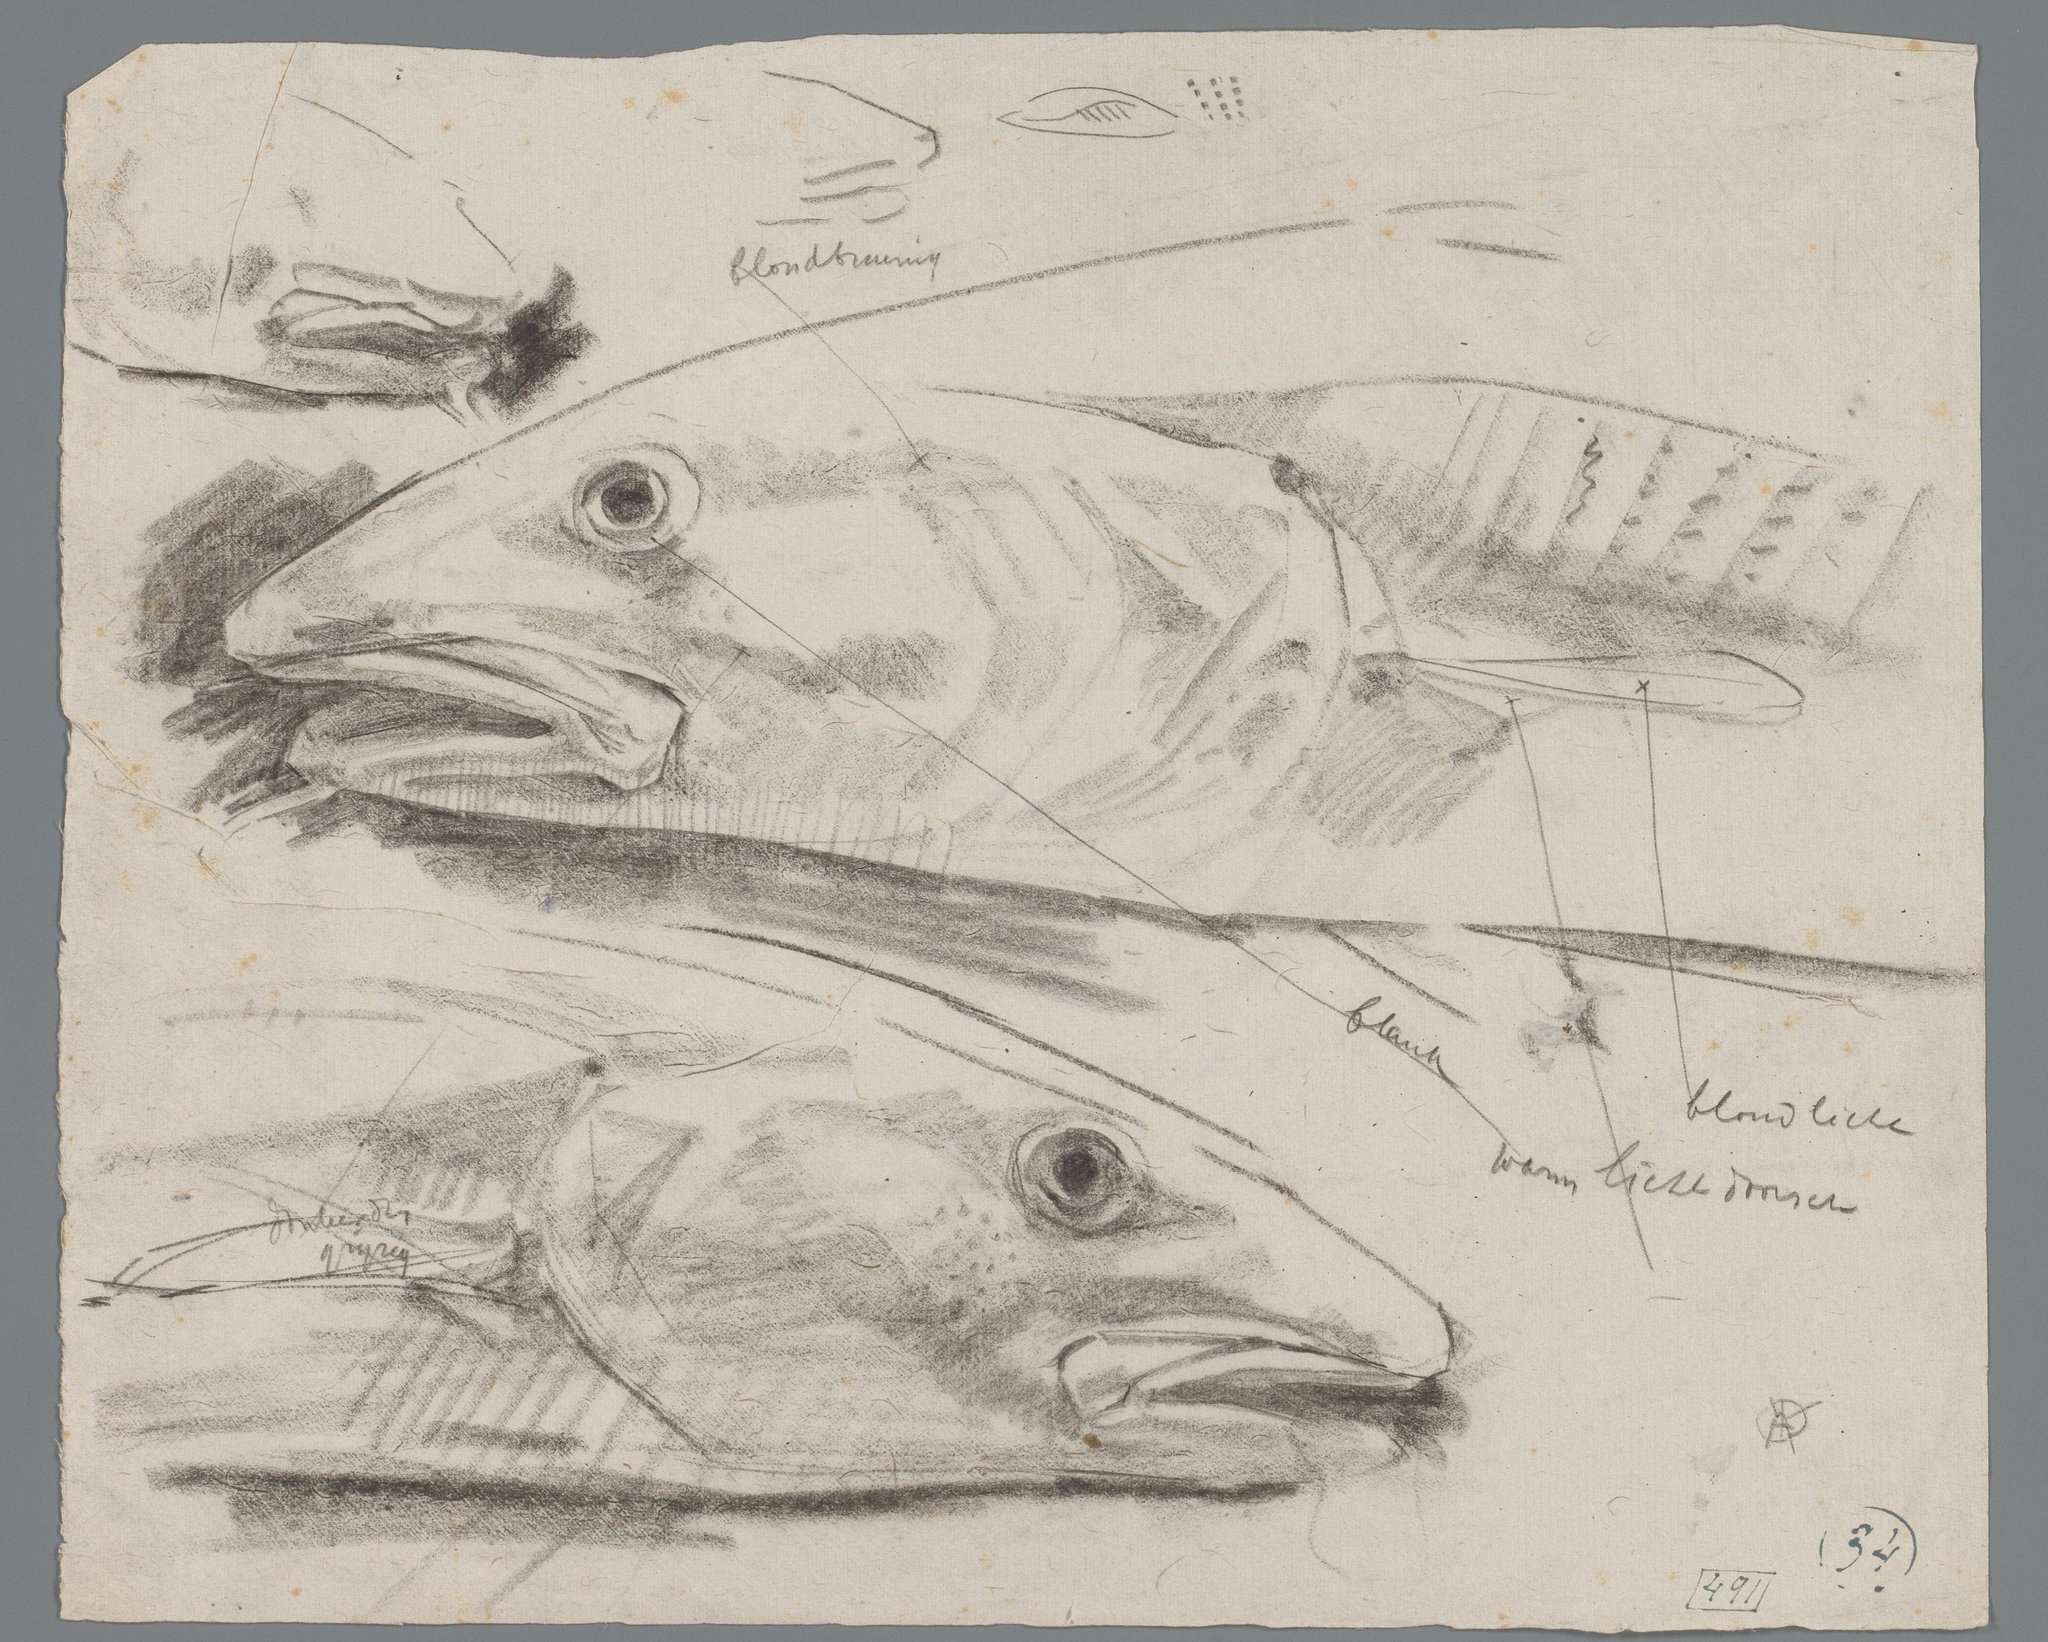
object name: drawing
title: Studies van een kabeljauw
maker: gerrit willem dijsselhof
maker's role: designer, draughtsman, print maker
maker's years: 1866-1924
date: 1876-1924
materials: chalk, paper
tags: fishes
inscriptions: number: ‘491’, number: ‘34’